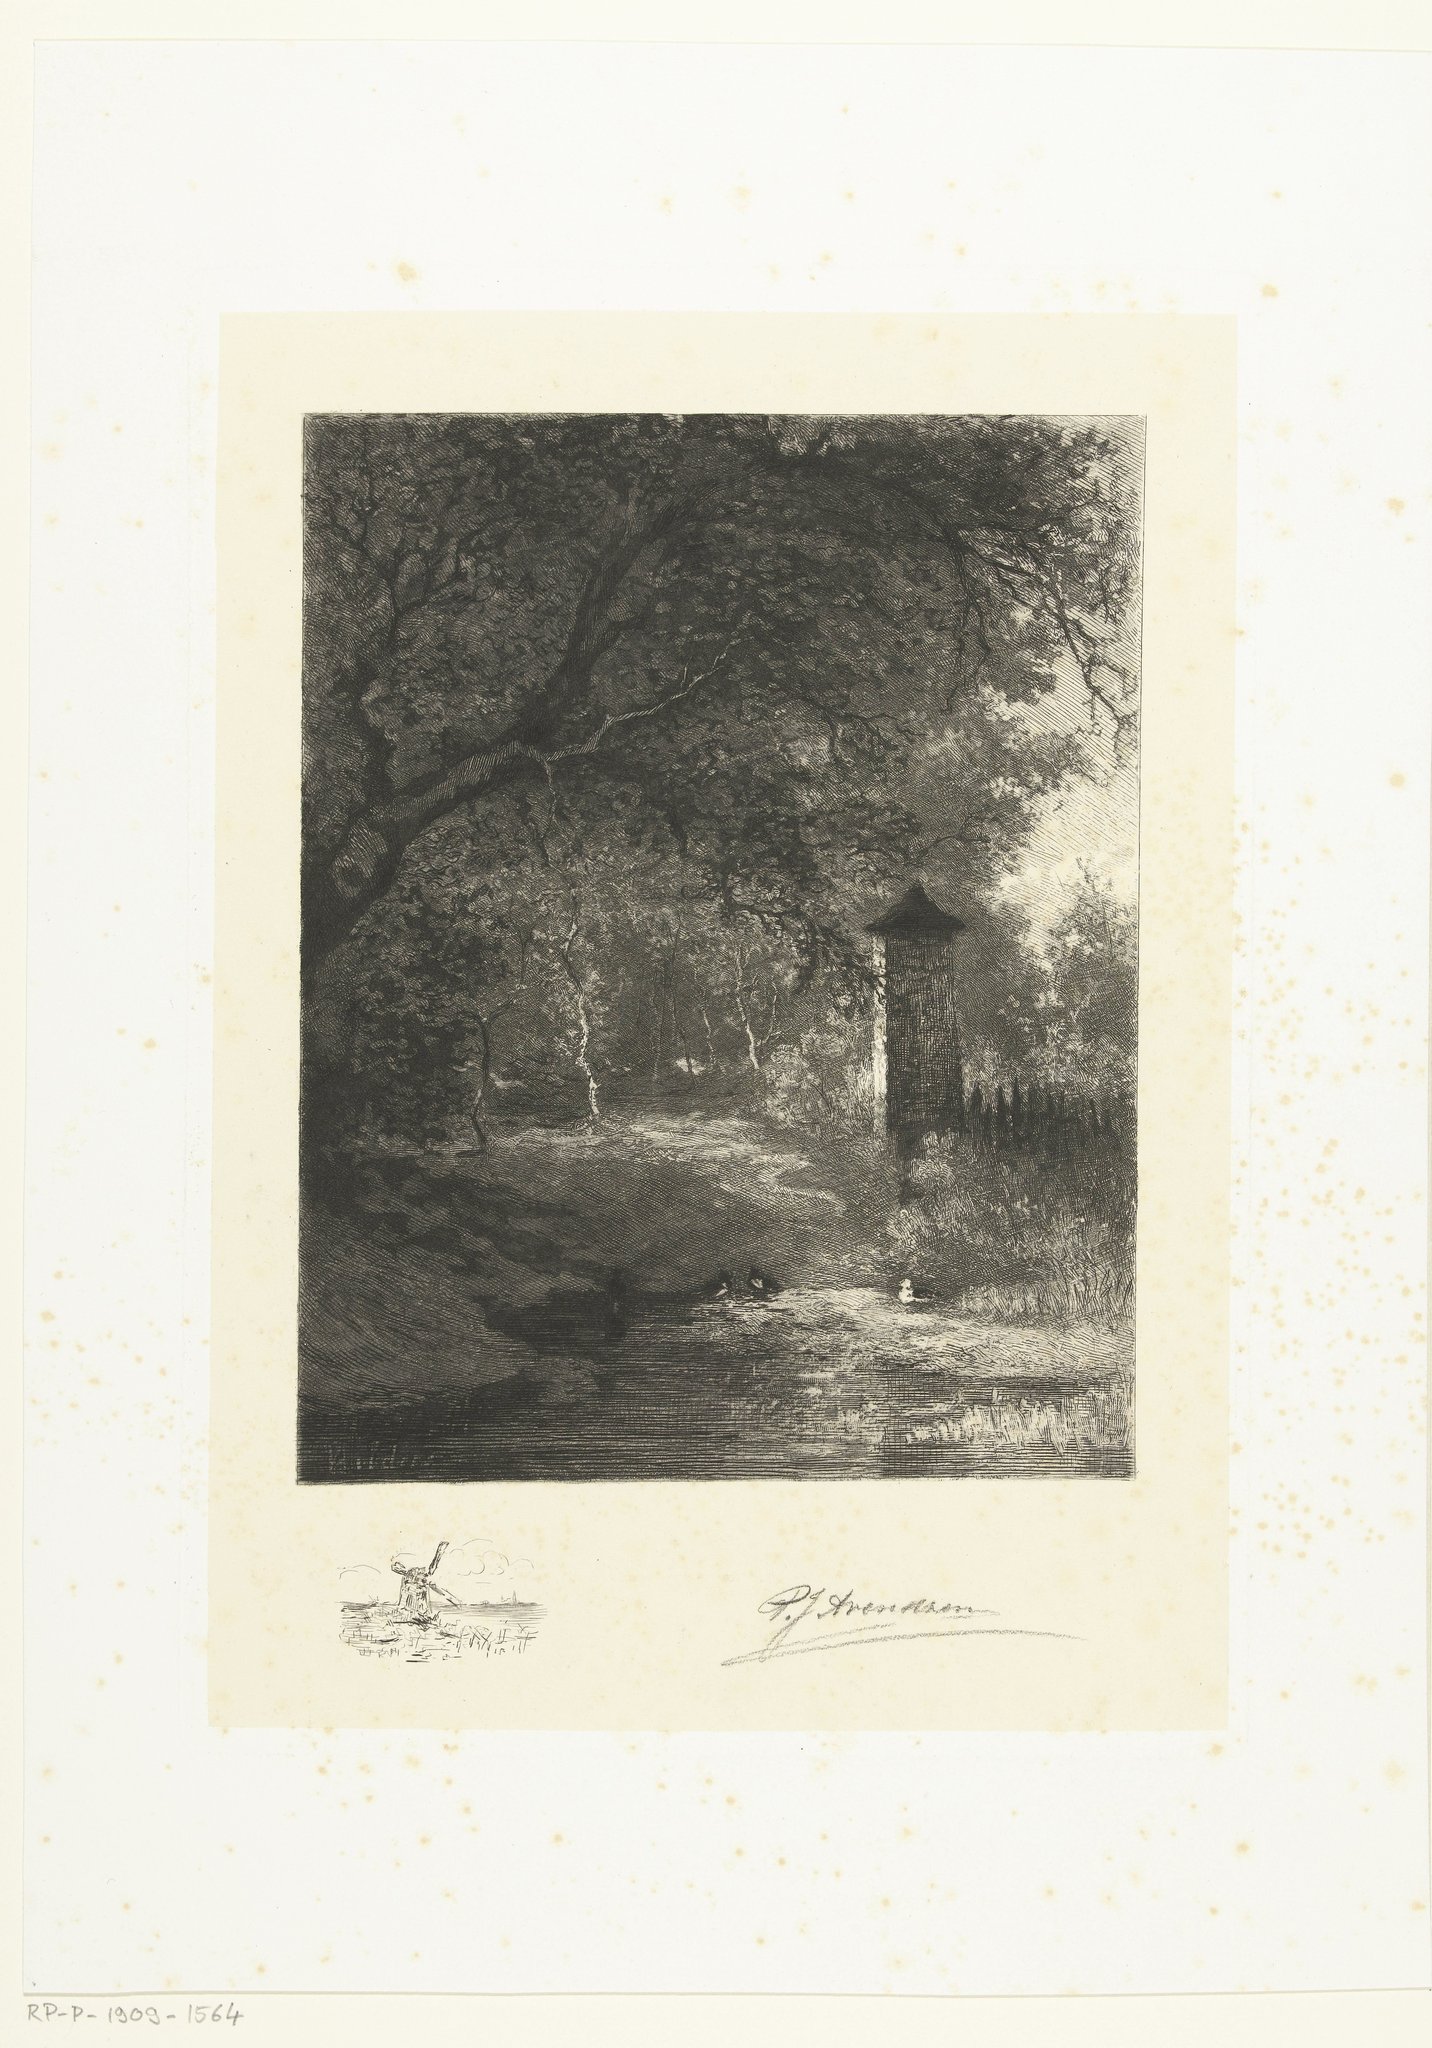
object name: print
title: Bosgezicht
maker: petrus johannes arendzen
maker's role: draughtsman, print maker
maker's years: 1846-1932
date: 1856-1909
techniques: printmaking, etching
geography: netherlands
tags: forest, wood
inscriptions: collector's mark: Lugt 2228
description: Bosgezicht met vijver en eenden. In marge een landschap met molen.